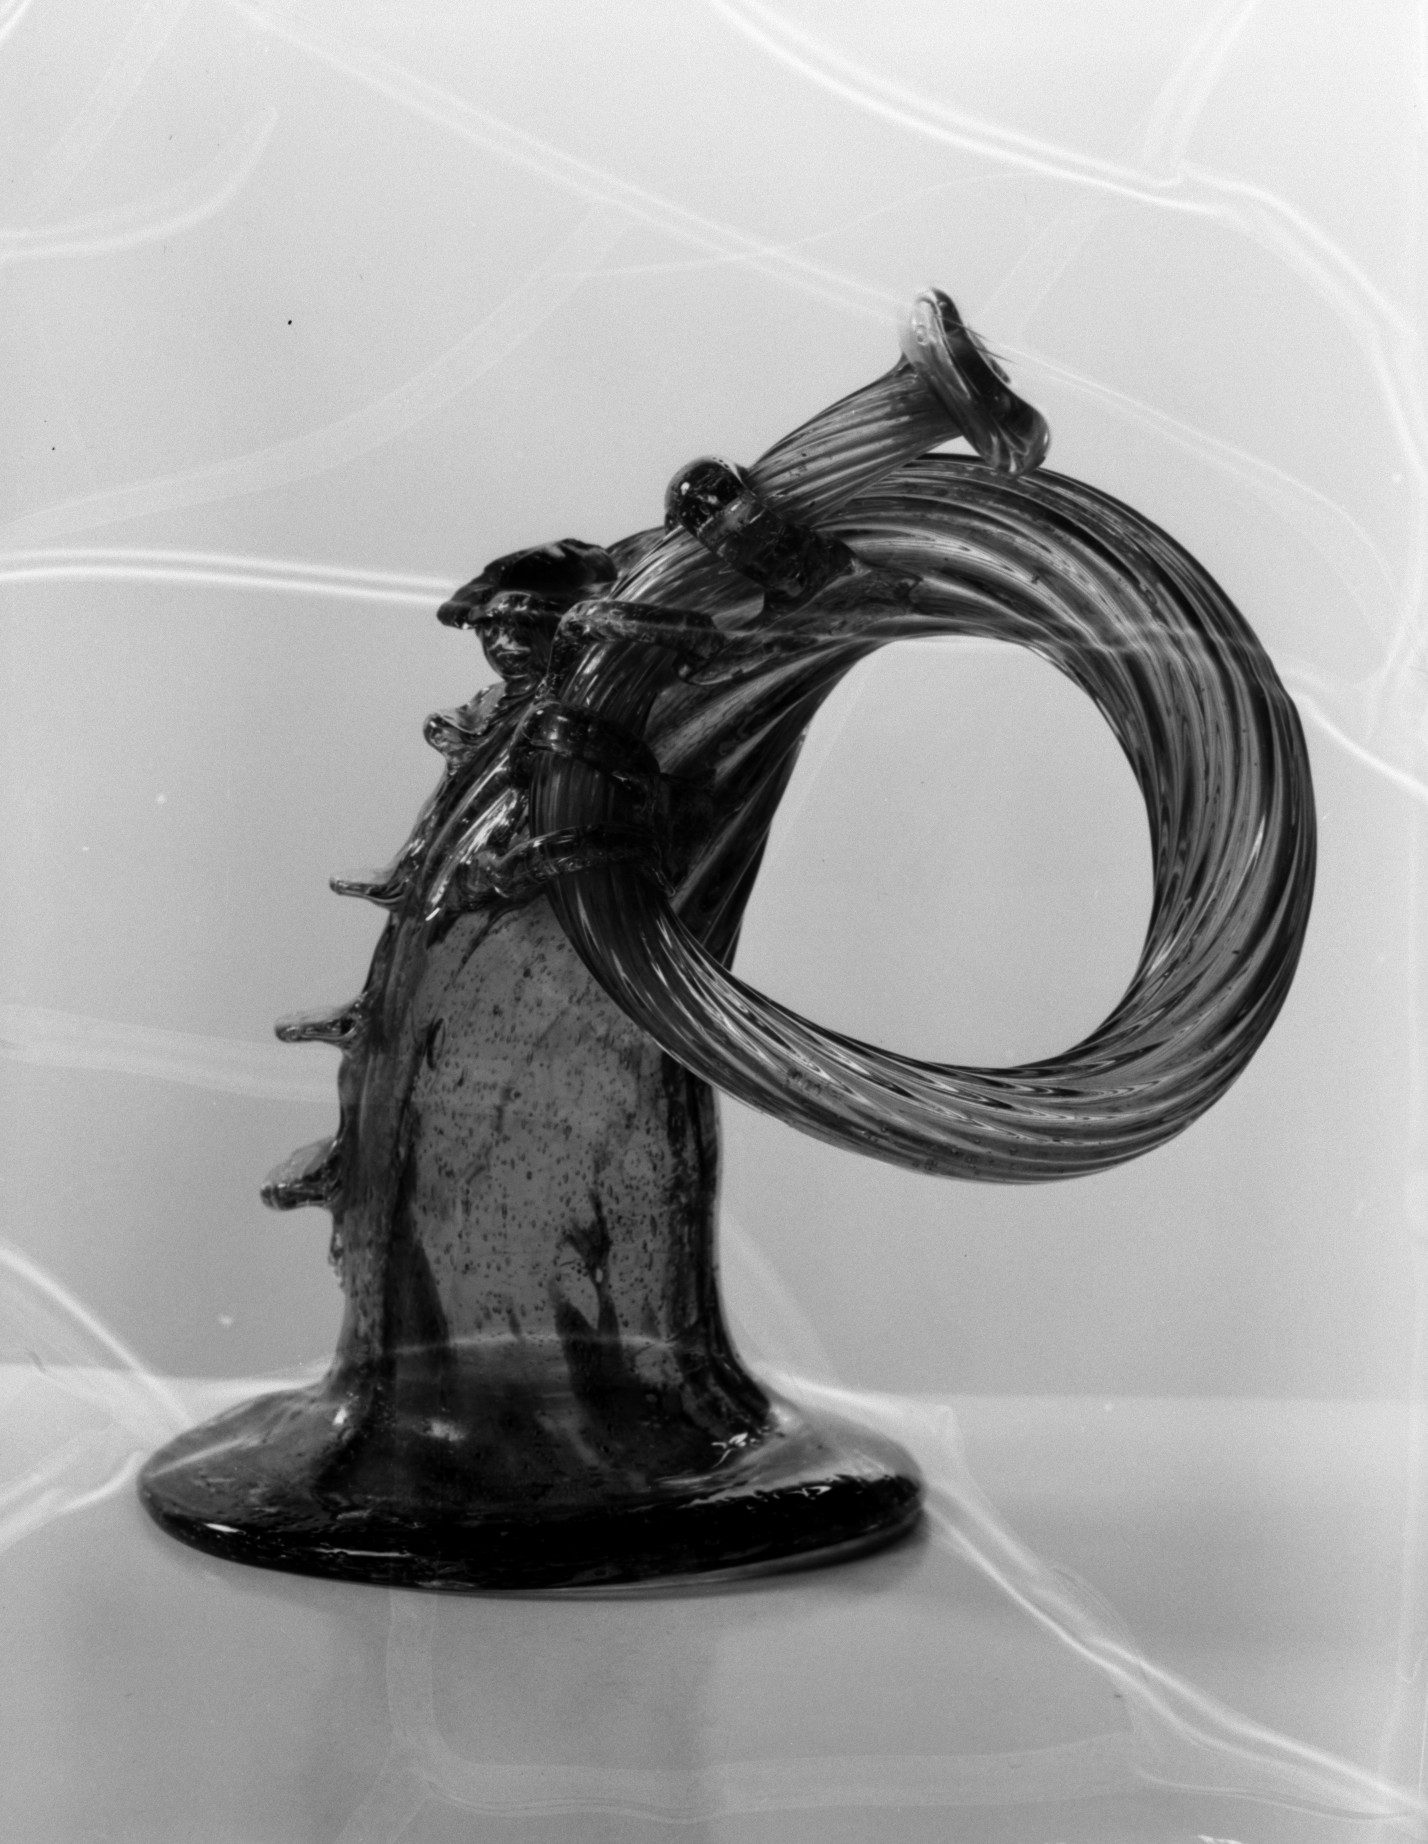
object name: horn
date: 1701-1800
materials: glass